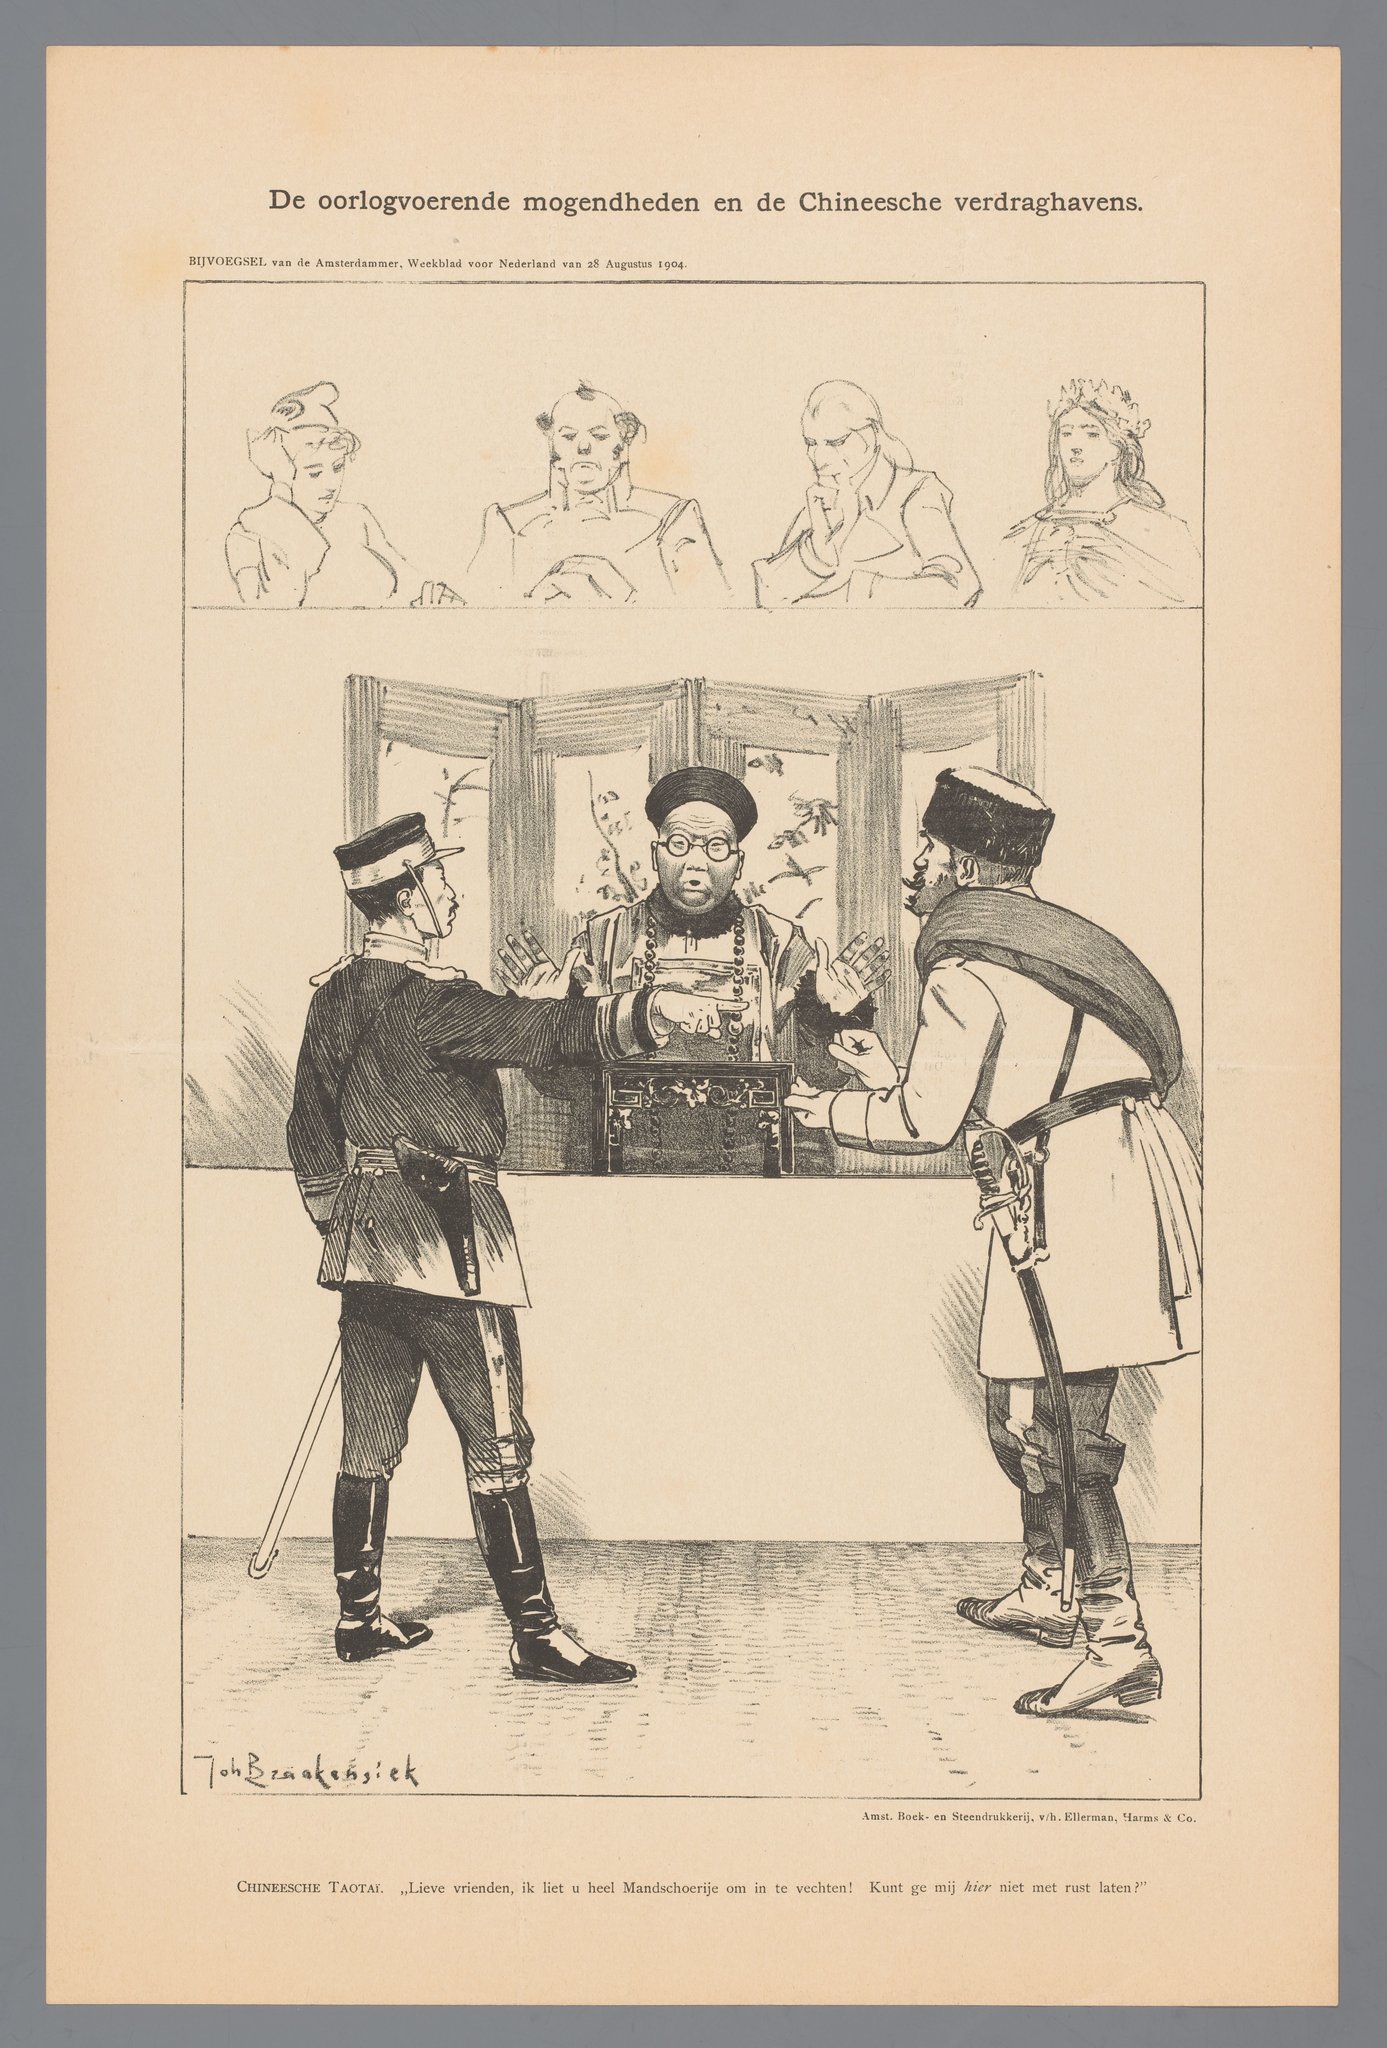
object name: cartoon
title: De oorlogvoerende mogendheden en de Chineesche verdraghavens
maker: johan braakensiek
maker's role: draughtsman, print maker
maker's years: 1858-1940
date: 1904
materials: paper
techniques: lithograph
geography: amsterdam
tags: personifications of countries, nations, states, districts, etc. (+ nation; national), political caricatures and satires, china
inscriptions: date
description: Prent uit het bijvoegsel van: De Amsterdammer. Weekblad voor Nederland, 28 augustus 1904.